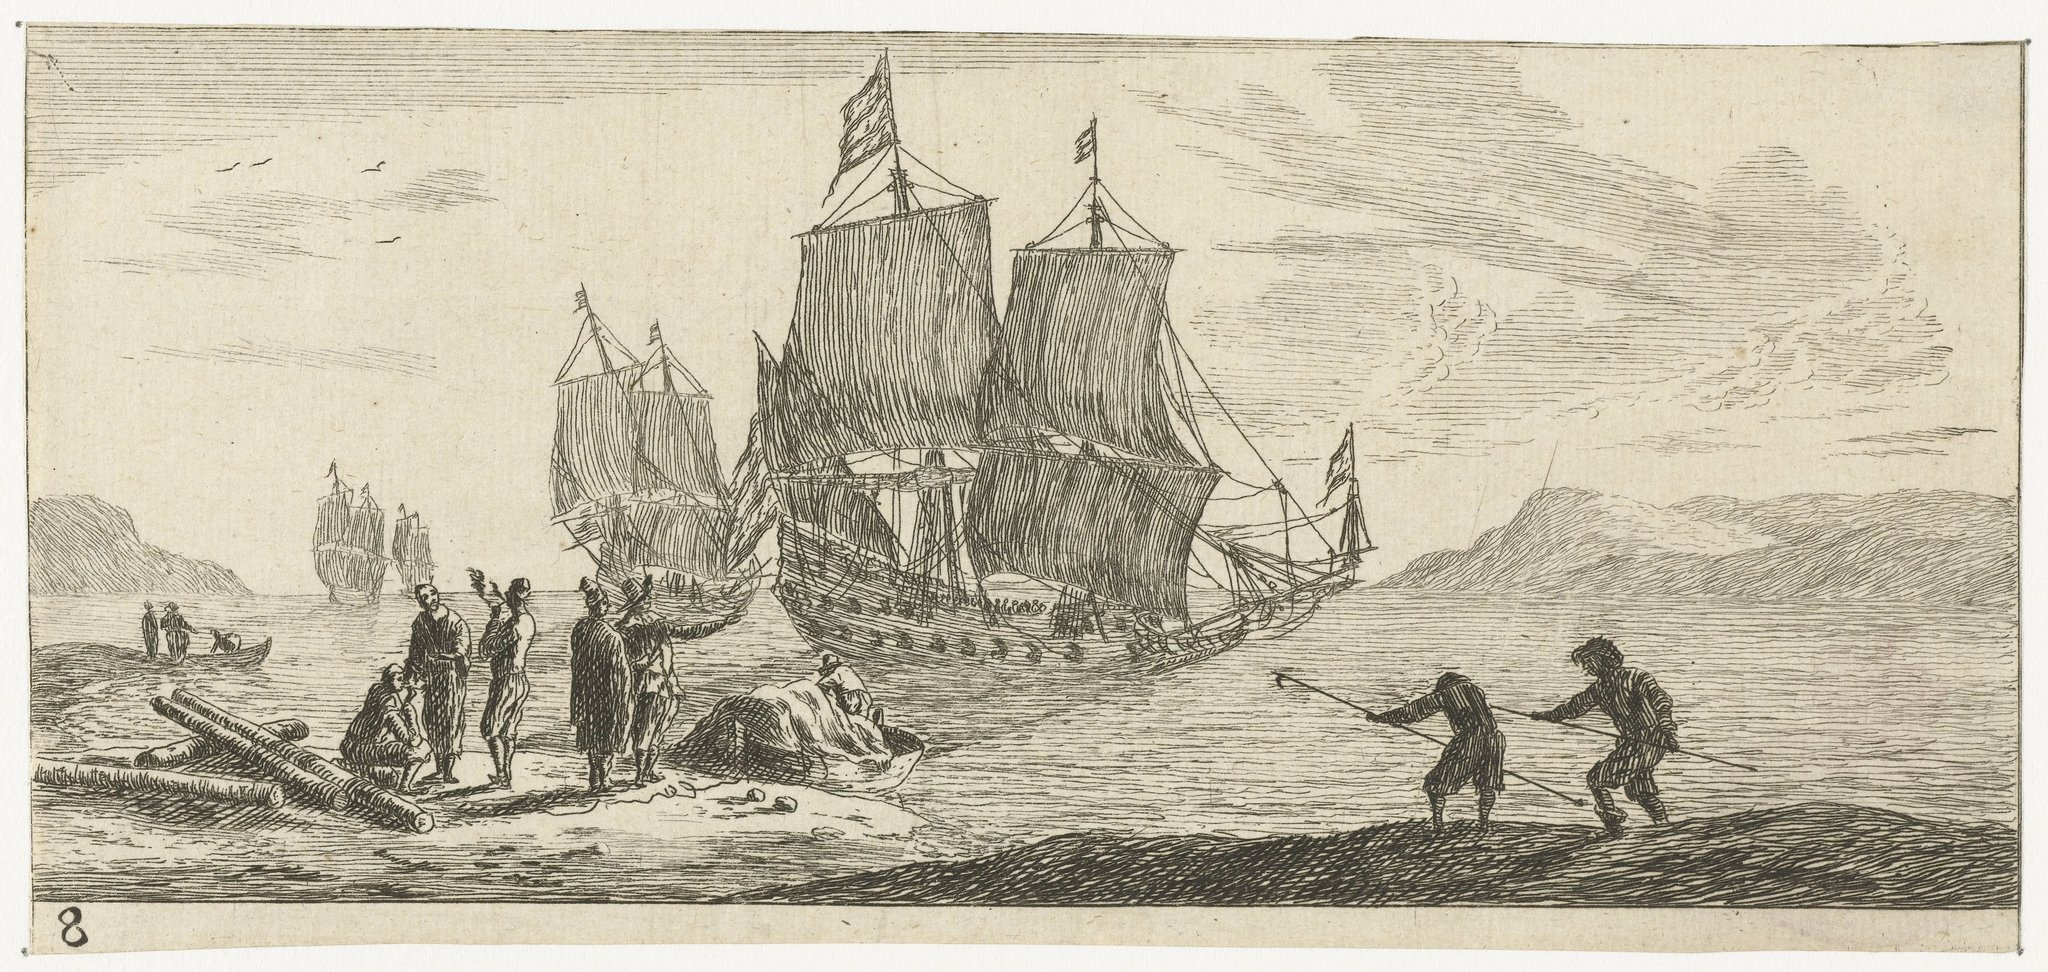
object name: print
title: Divers Embarquements et autre Faicts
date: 1651-1652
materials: paper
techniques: engraving, etching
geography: netherlands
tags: gulf, bay, sailing-ship, sailing-boat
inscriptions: collector's mark: Lugt 12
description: Een baai met vier grote zeilschepen, een groep mannen op de kust bij een roeiboot en twee mannen met harpoenen.